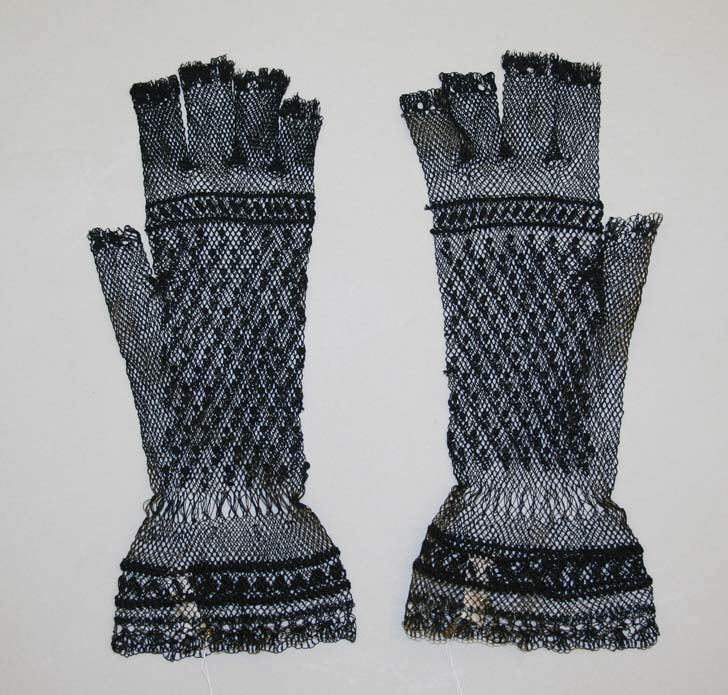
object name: mitt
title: Mitts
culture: american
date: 1801-1900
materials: silk